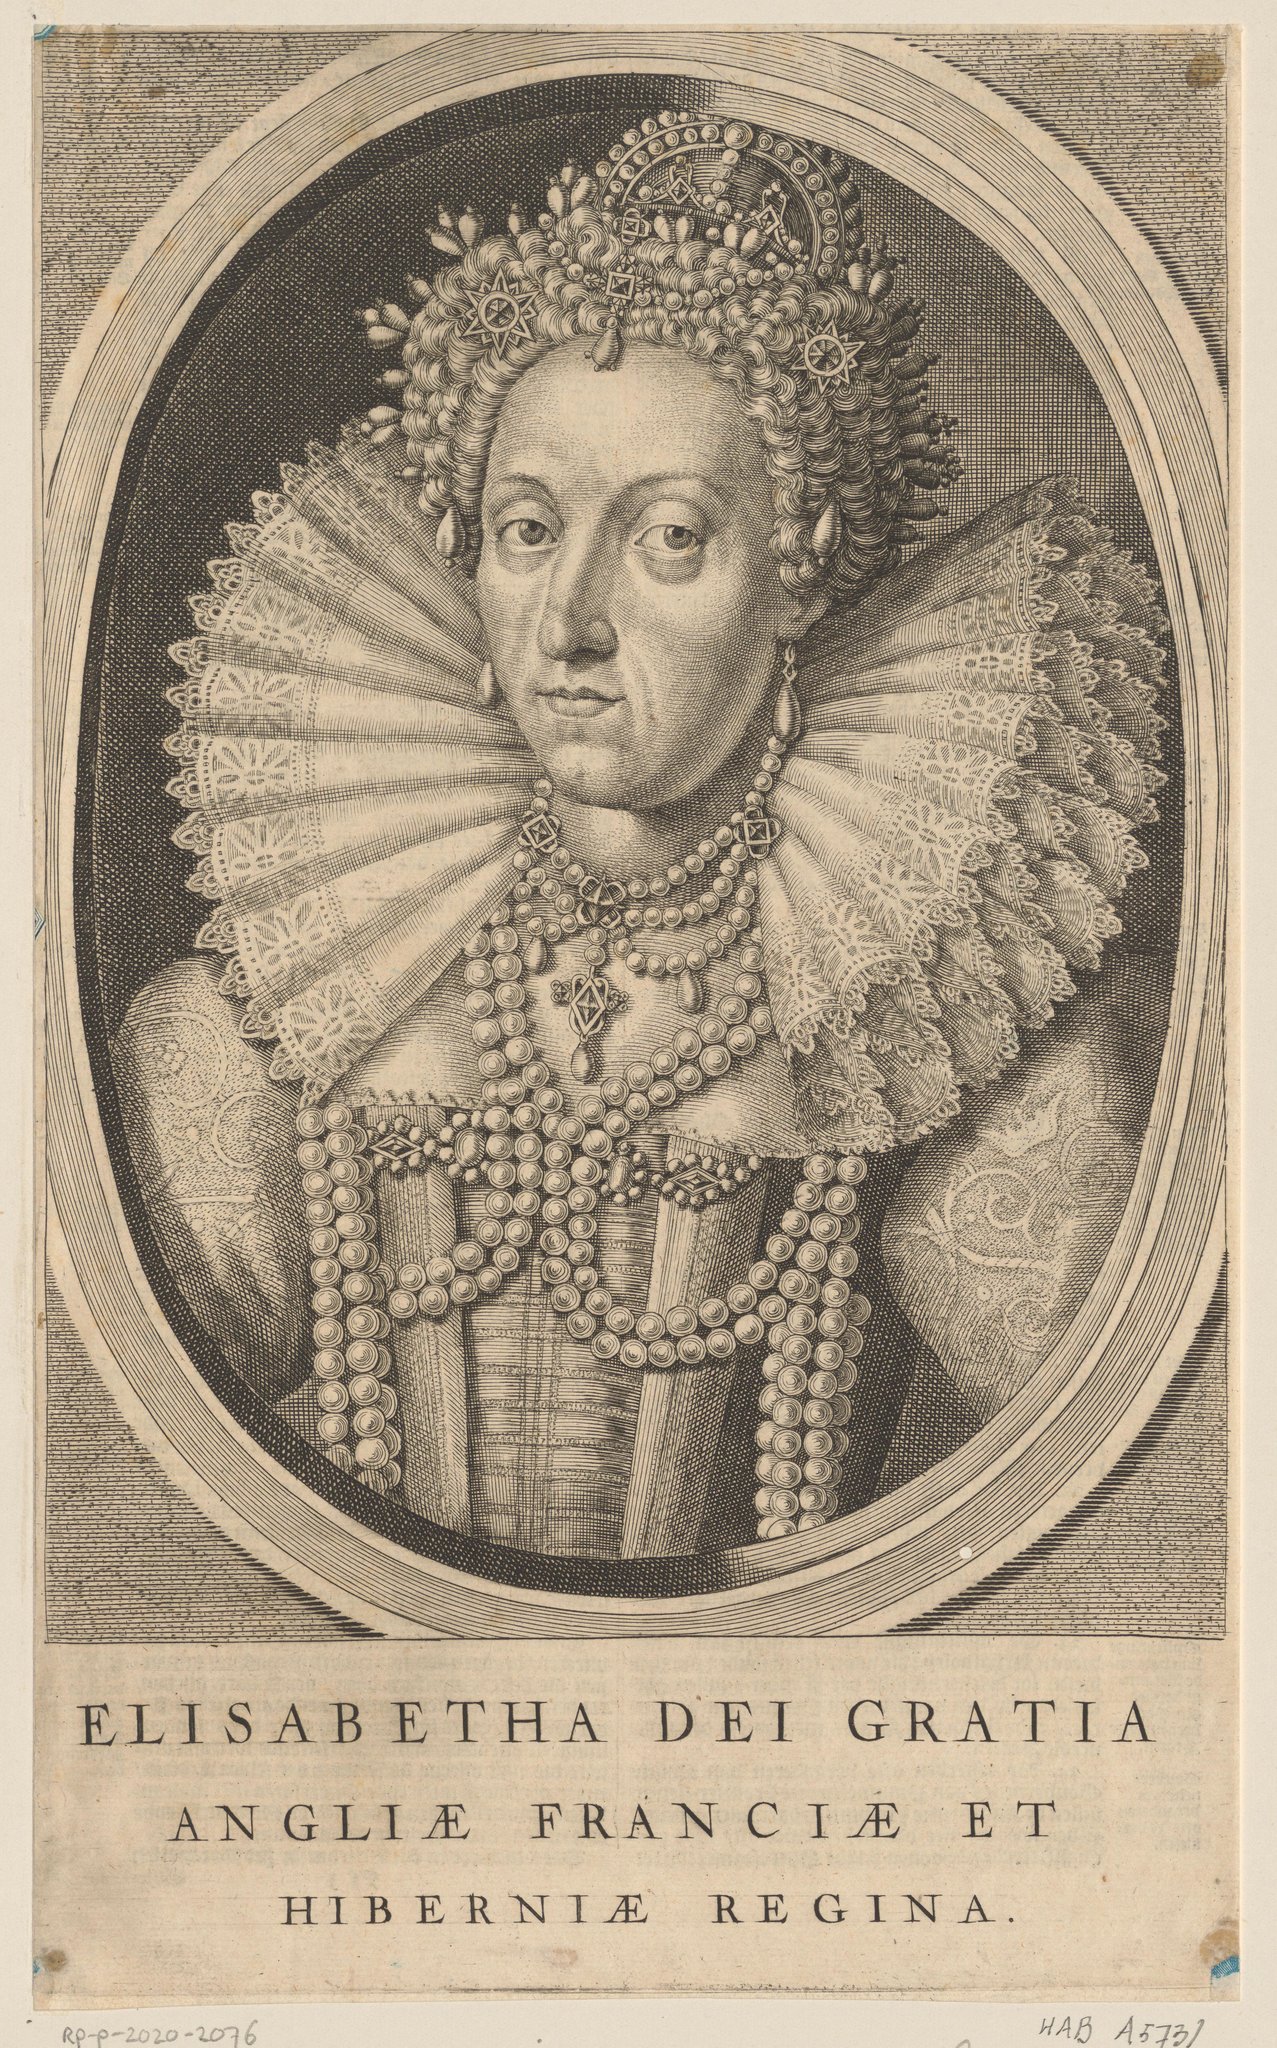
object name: print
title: Portret van Elizabeth I Tudor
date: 1647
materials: paper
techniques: engraving, letterpress printing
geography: amsterdam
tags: historical persons - bb - woman, queen, pearl; pearl necklace, crown (symbol of sovereignty) - bb - female ruler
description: Prent uit: Meteren, Emanuel van. Historien der Nederlanden, en haar naburen oorlogen tot het jaar 1612. Amsterdam: Jan Jacobsz Schipper, 1647. Prent mogelijk gebruikt in eerdere edities van het boek.